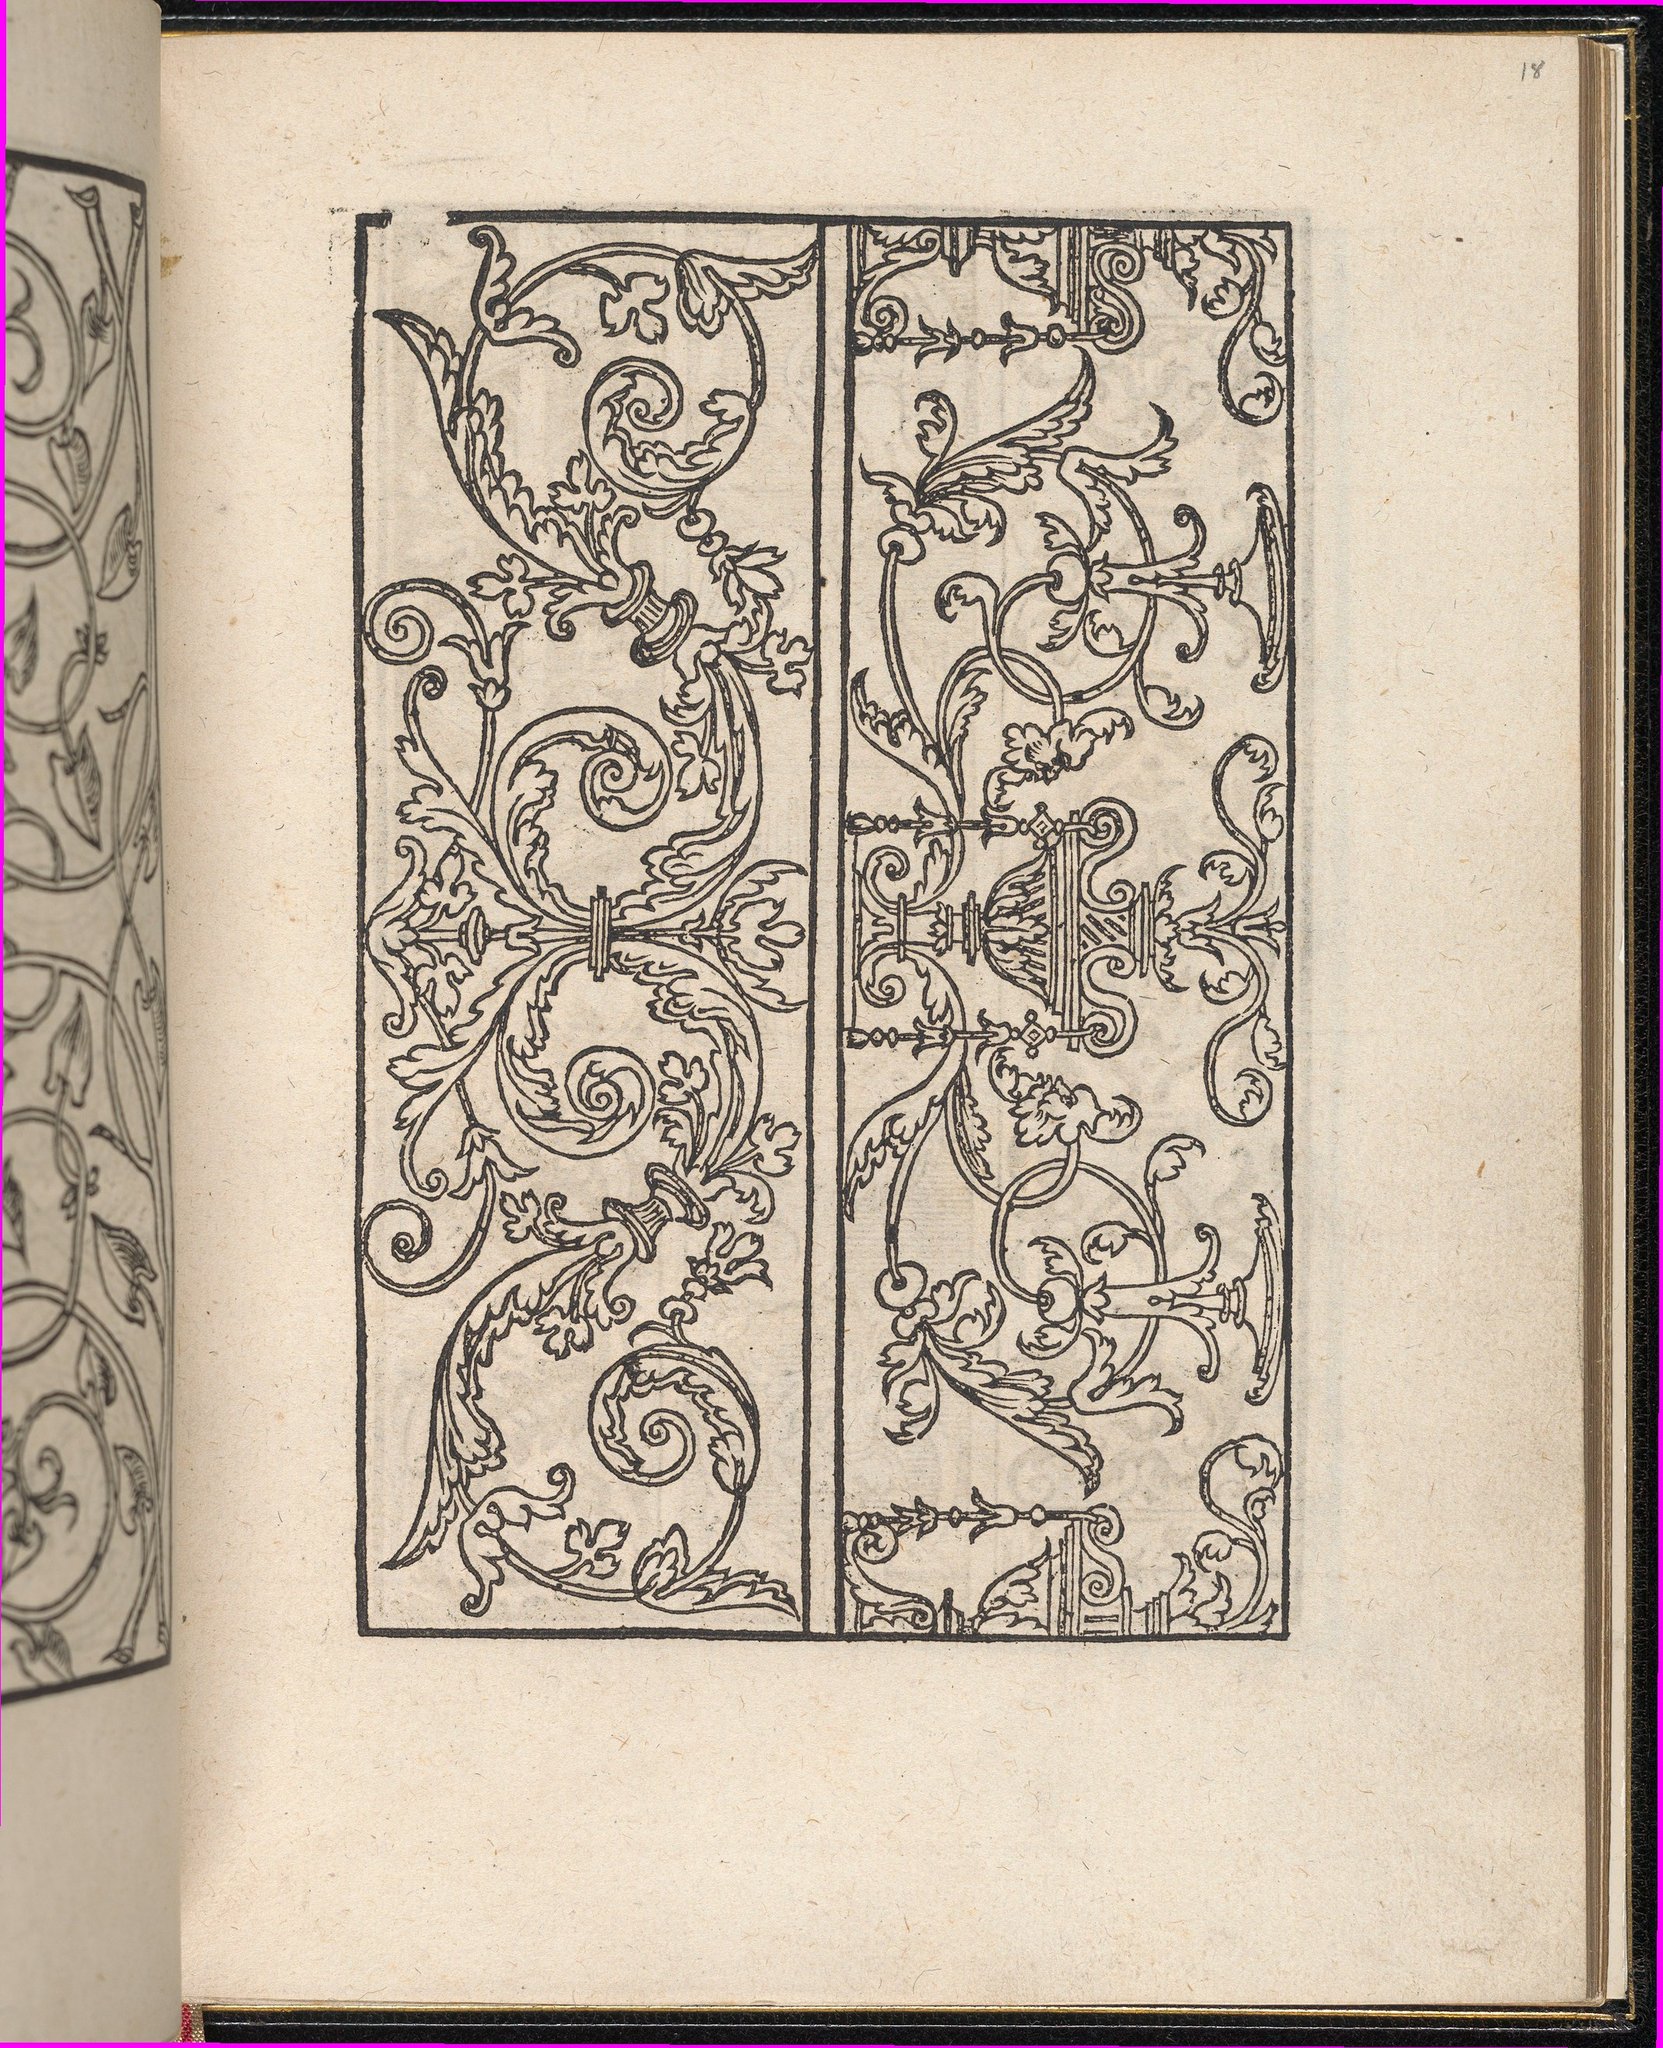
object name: book print ornament architecture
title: Page from Ein new kunstlich Modelbuch...(Page 17v)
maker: peter quentel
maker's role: publisher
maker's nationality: german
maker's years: 1500-1550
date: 1544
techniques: woodcut